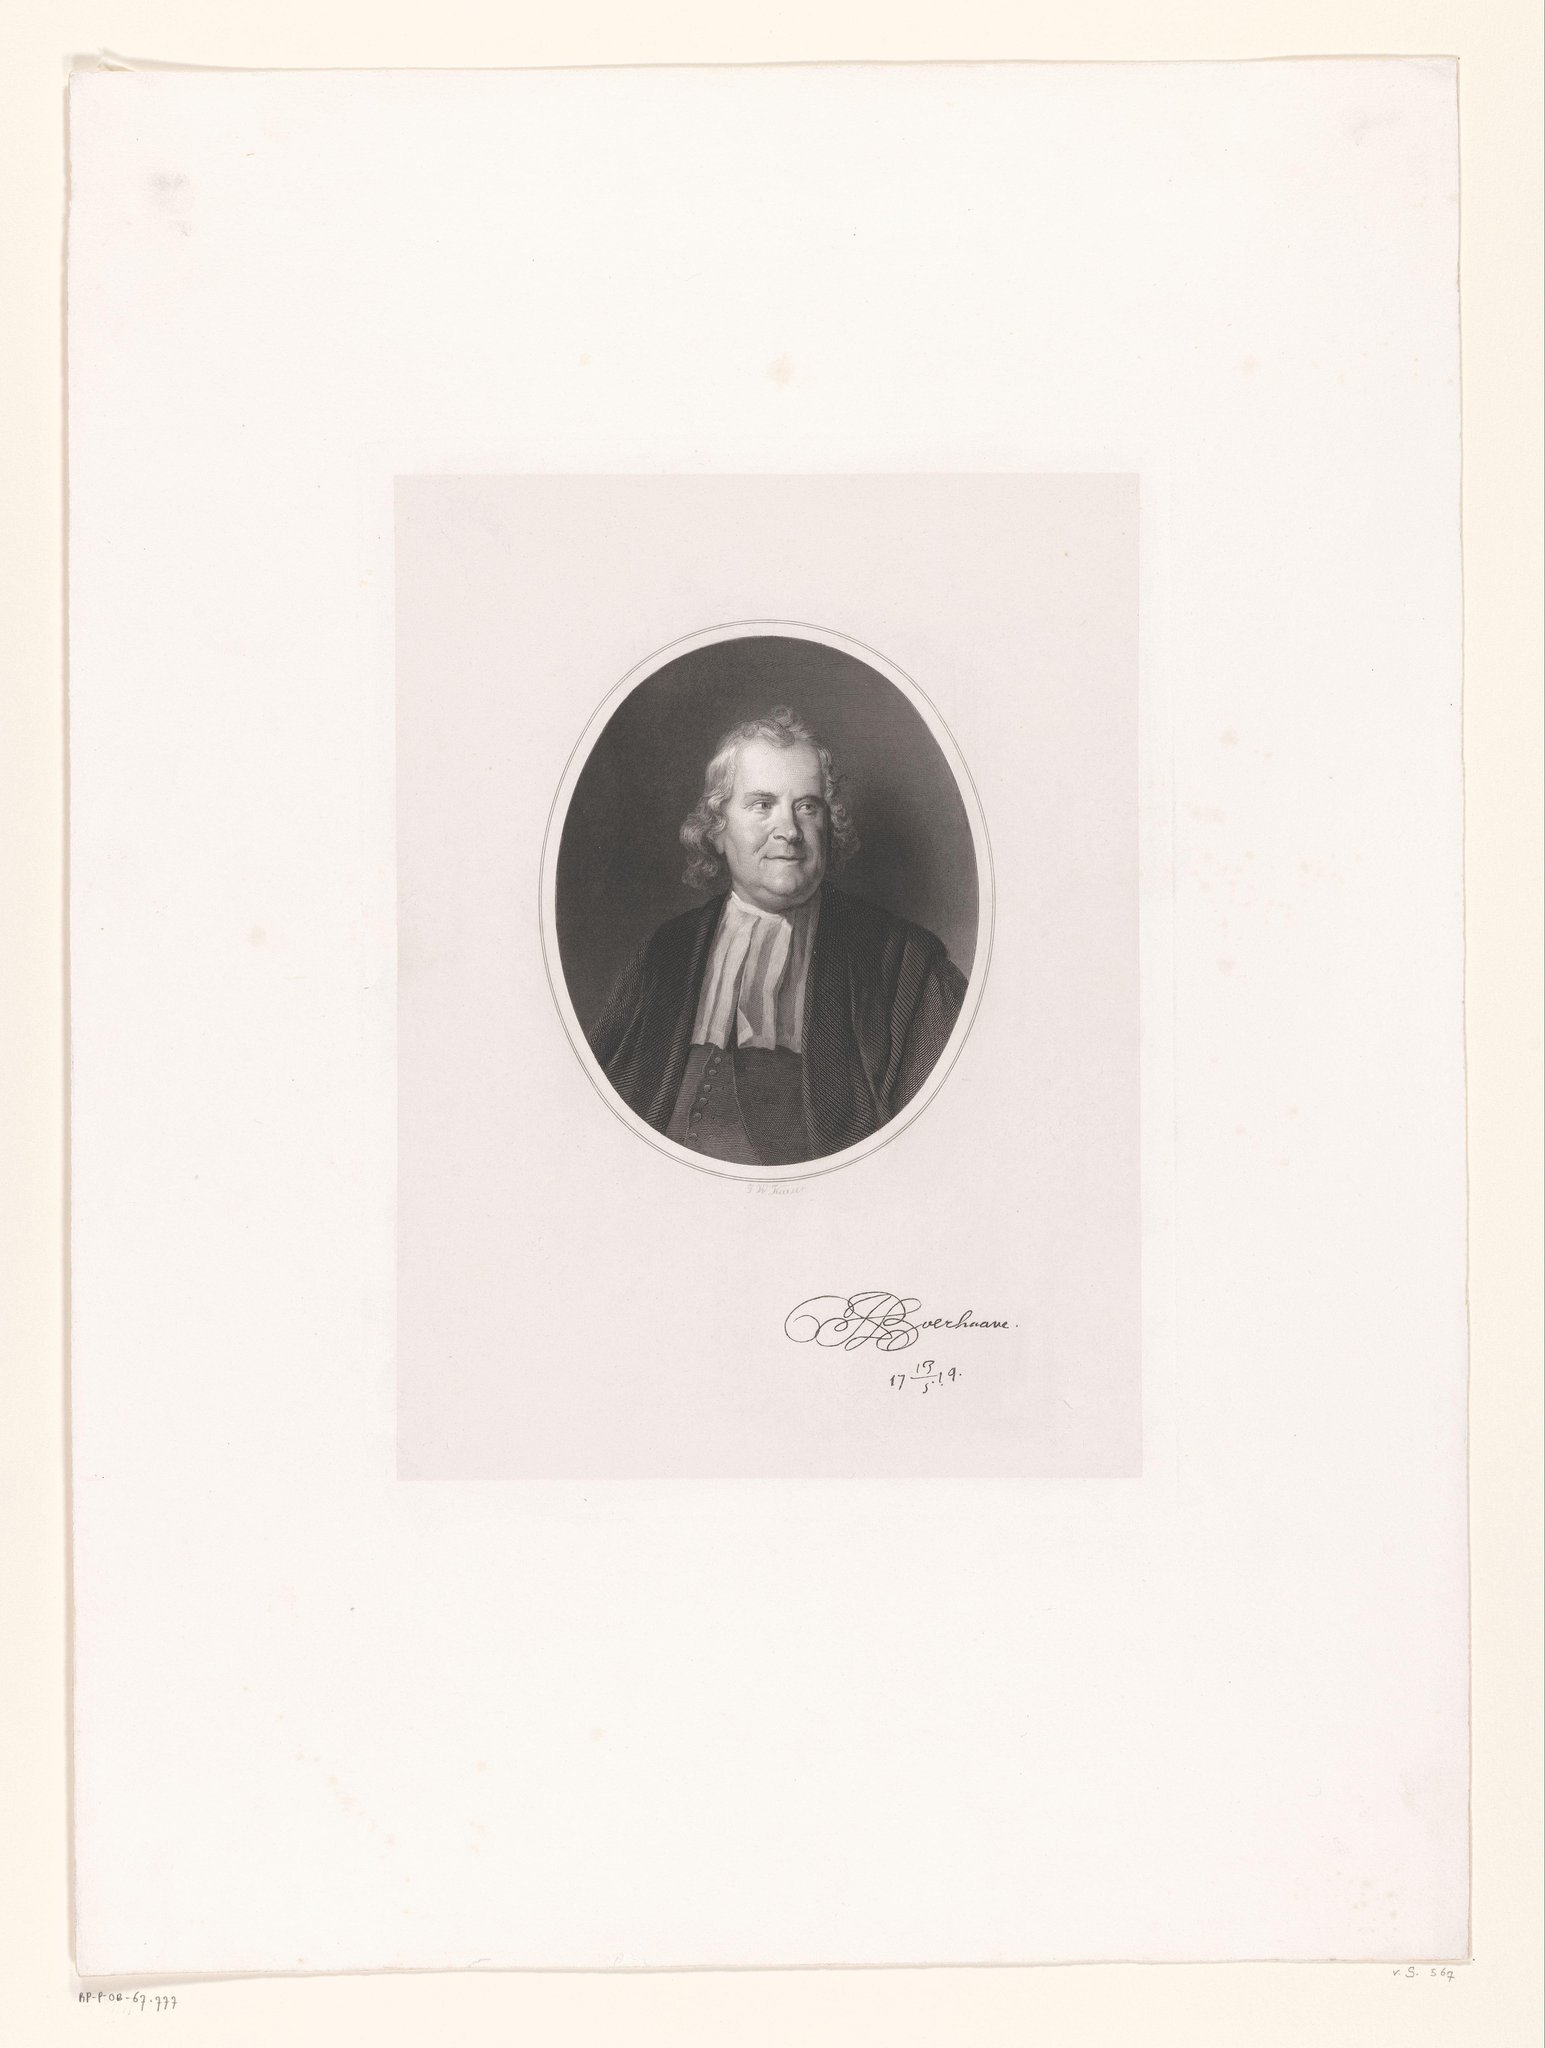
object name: print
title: Portret van Hermanus Boerhaave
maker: johann wilhelm kaiser (i)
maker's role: draughtsman, print maker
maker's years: 1813-1900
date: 1823-1900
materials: paper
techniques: engraving, etching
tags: leiden, hermanus boerhaave, adult man, wise man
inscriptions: collector's mark: Lugt 2228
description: Portret van Hermanus Boerhaave (1668-1738), geneeskundige, hoogleraar aan de universiteit te Leiden.